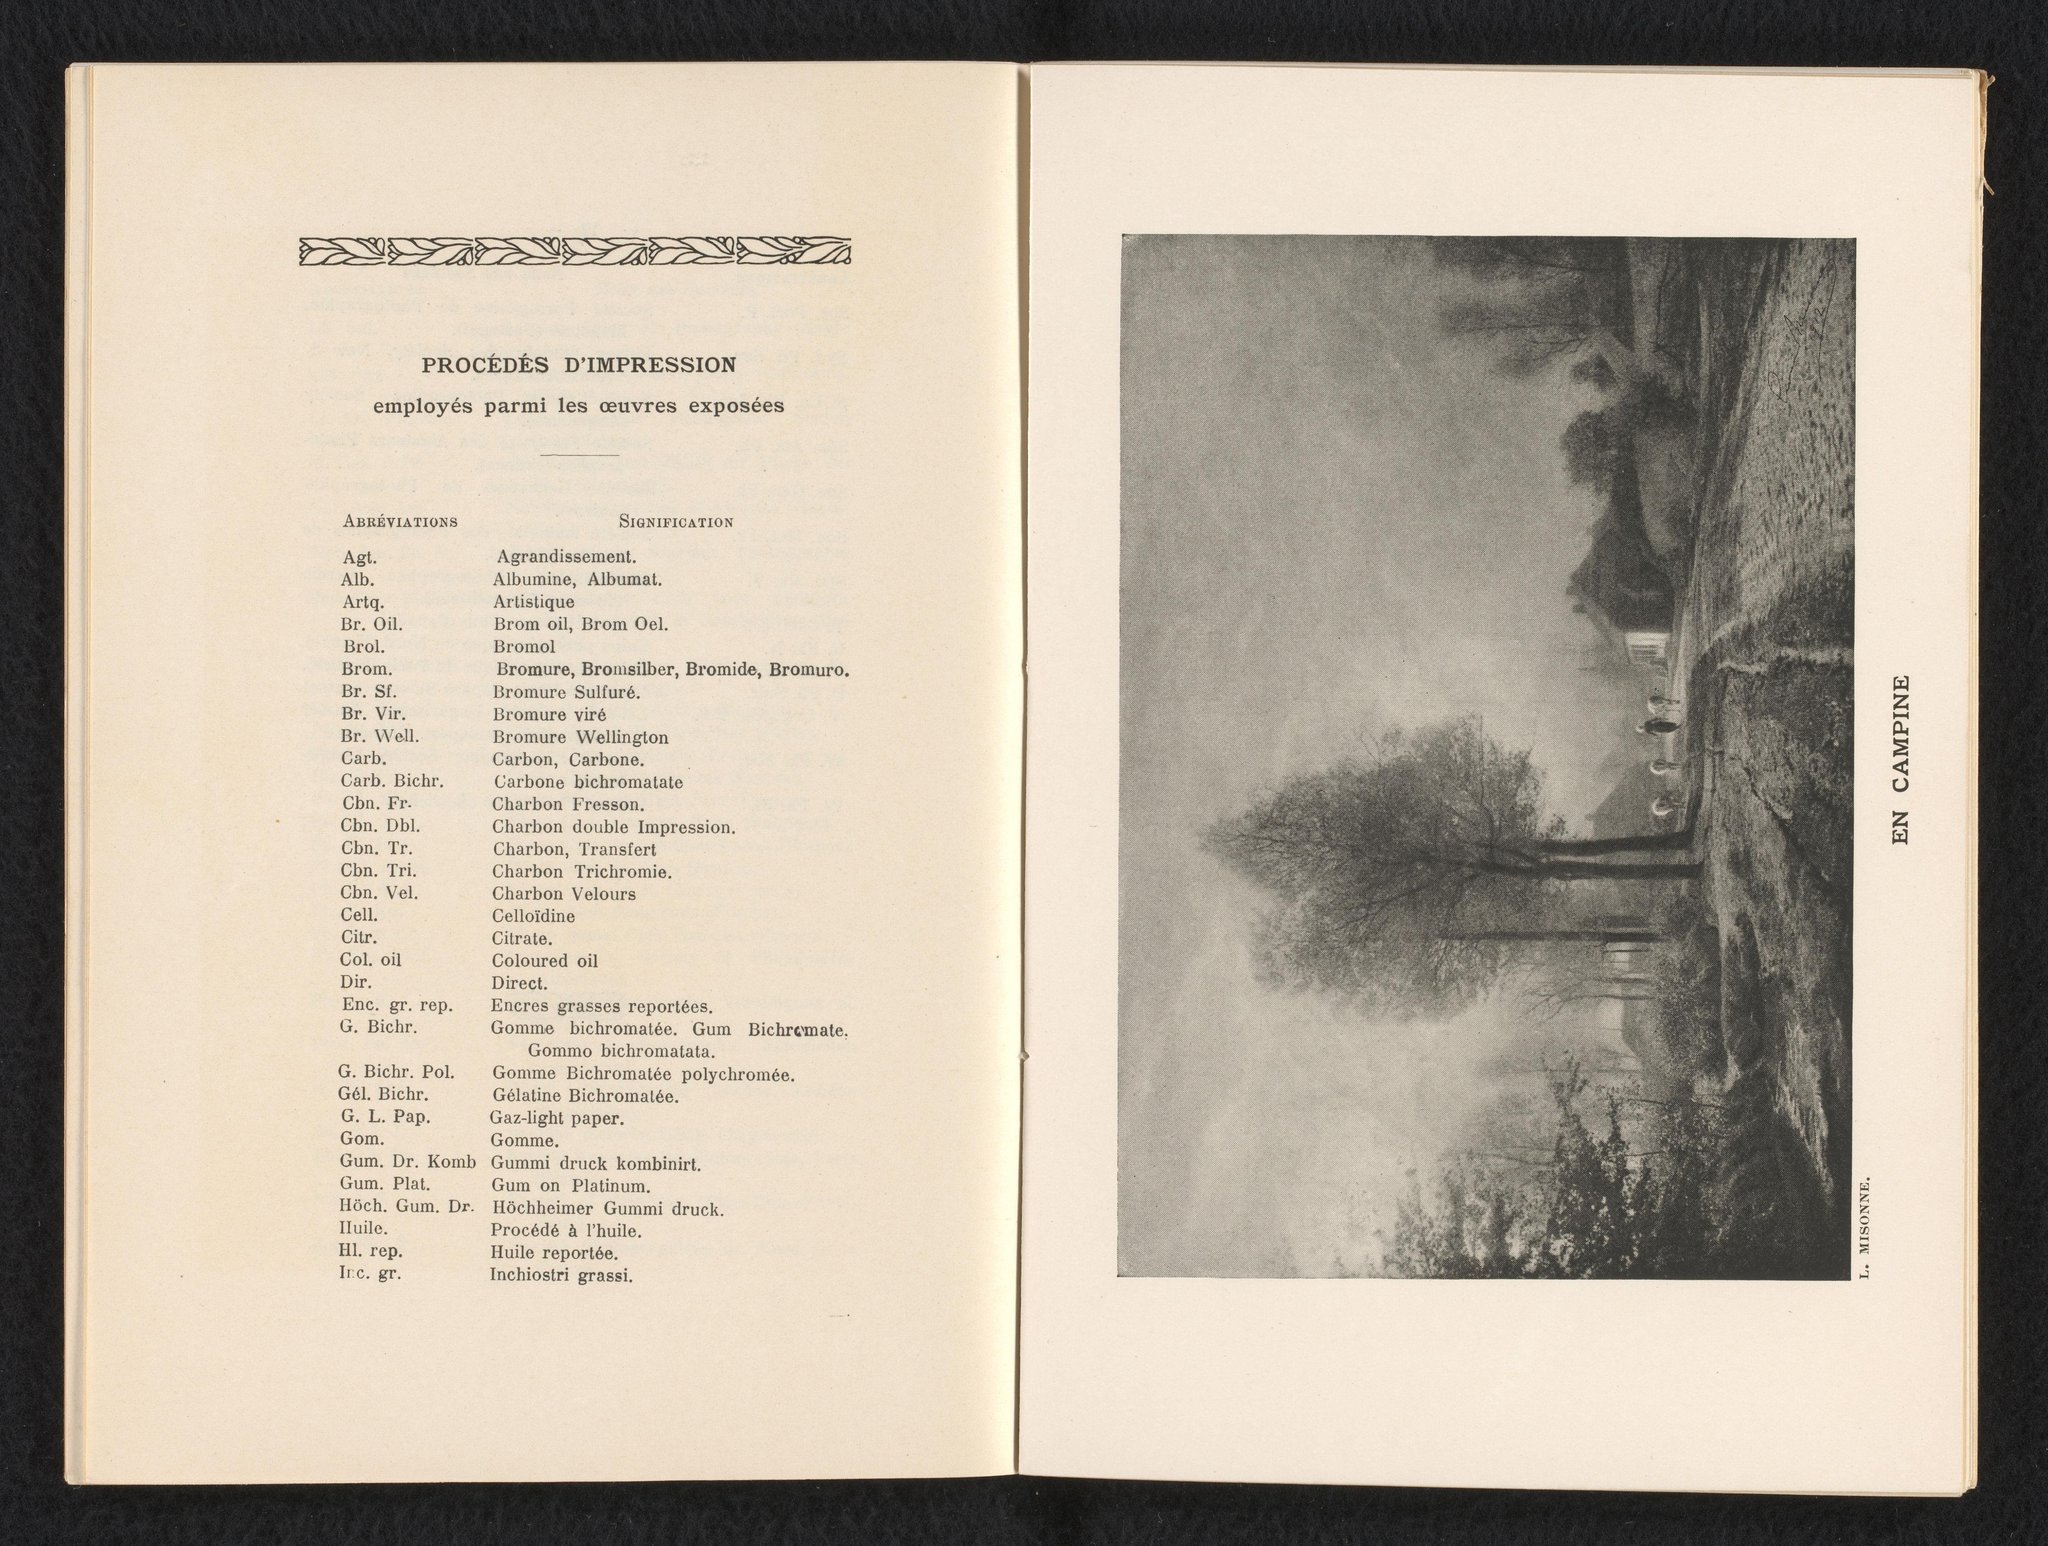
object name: photomechanical print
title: En campine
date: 1912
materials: paper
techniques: autotype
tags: rural housing, e.g. country-house, villa, cottage, road, path, bovine cattle, rural life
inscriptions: signature and date: ‘L[...] 1912’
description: Prent op tweede ongenummerde pagina na pagina 19.